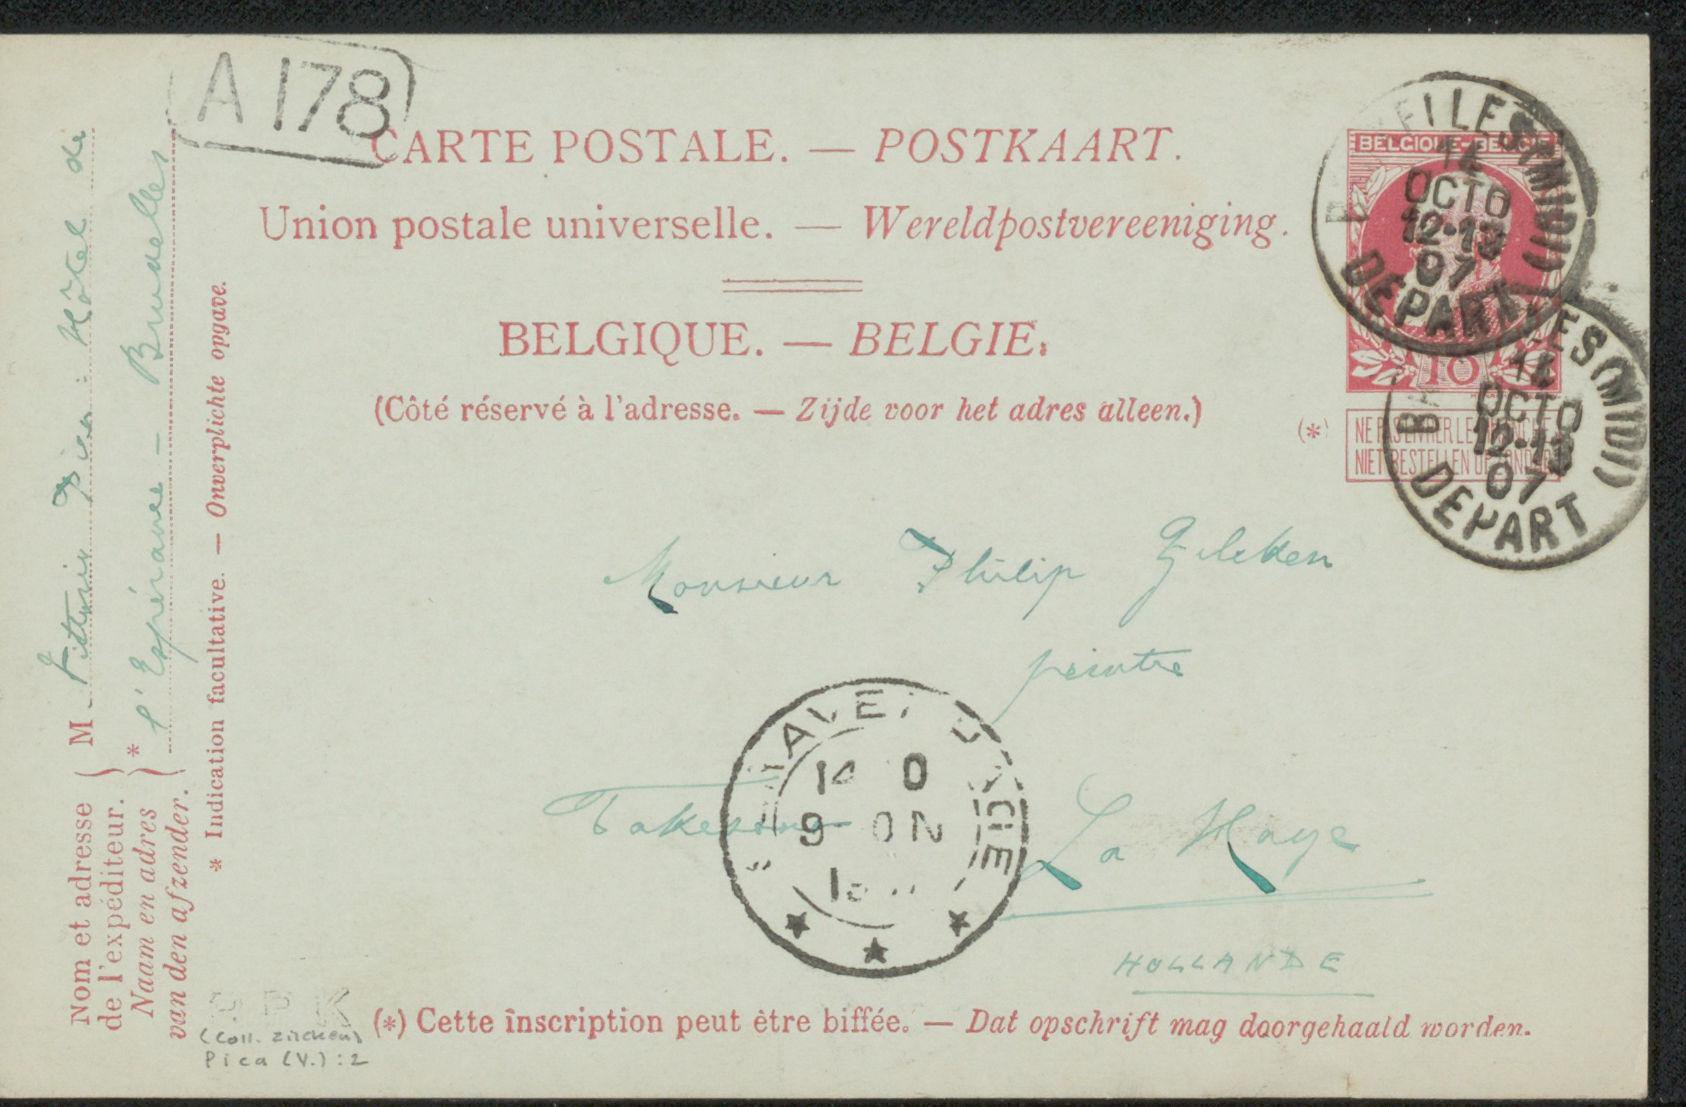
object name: postcard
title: Briefkaart aan Philip Zilcken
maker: vittorio pica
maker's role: criticus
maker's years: 1864-1930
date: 1907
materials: cardboard, ink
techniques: pen, writing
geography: brussels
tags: the hague, painter, draughtsman, philip zilcken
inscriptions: collector's mark: ‘RPK’